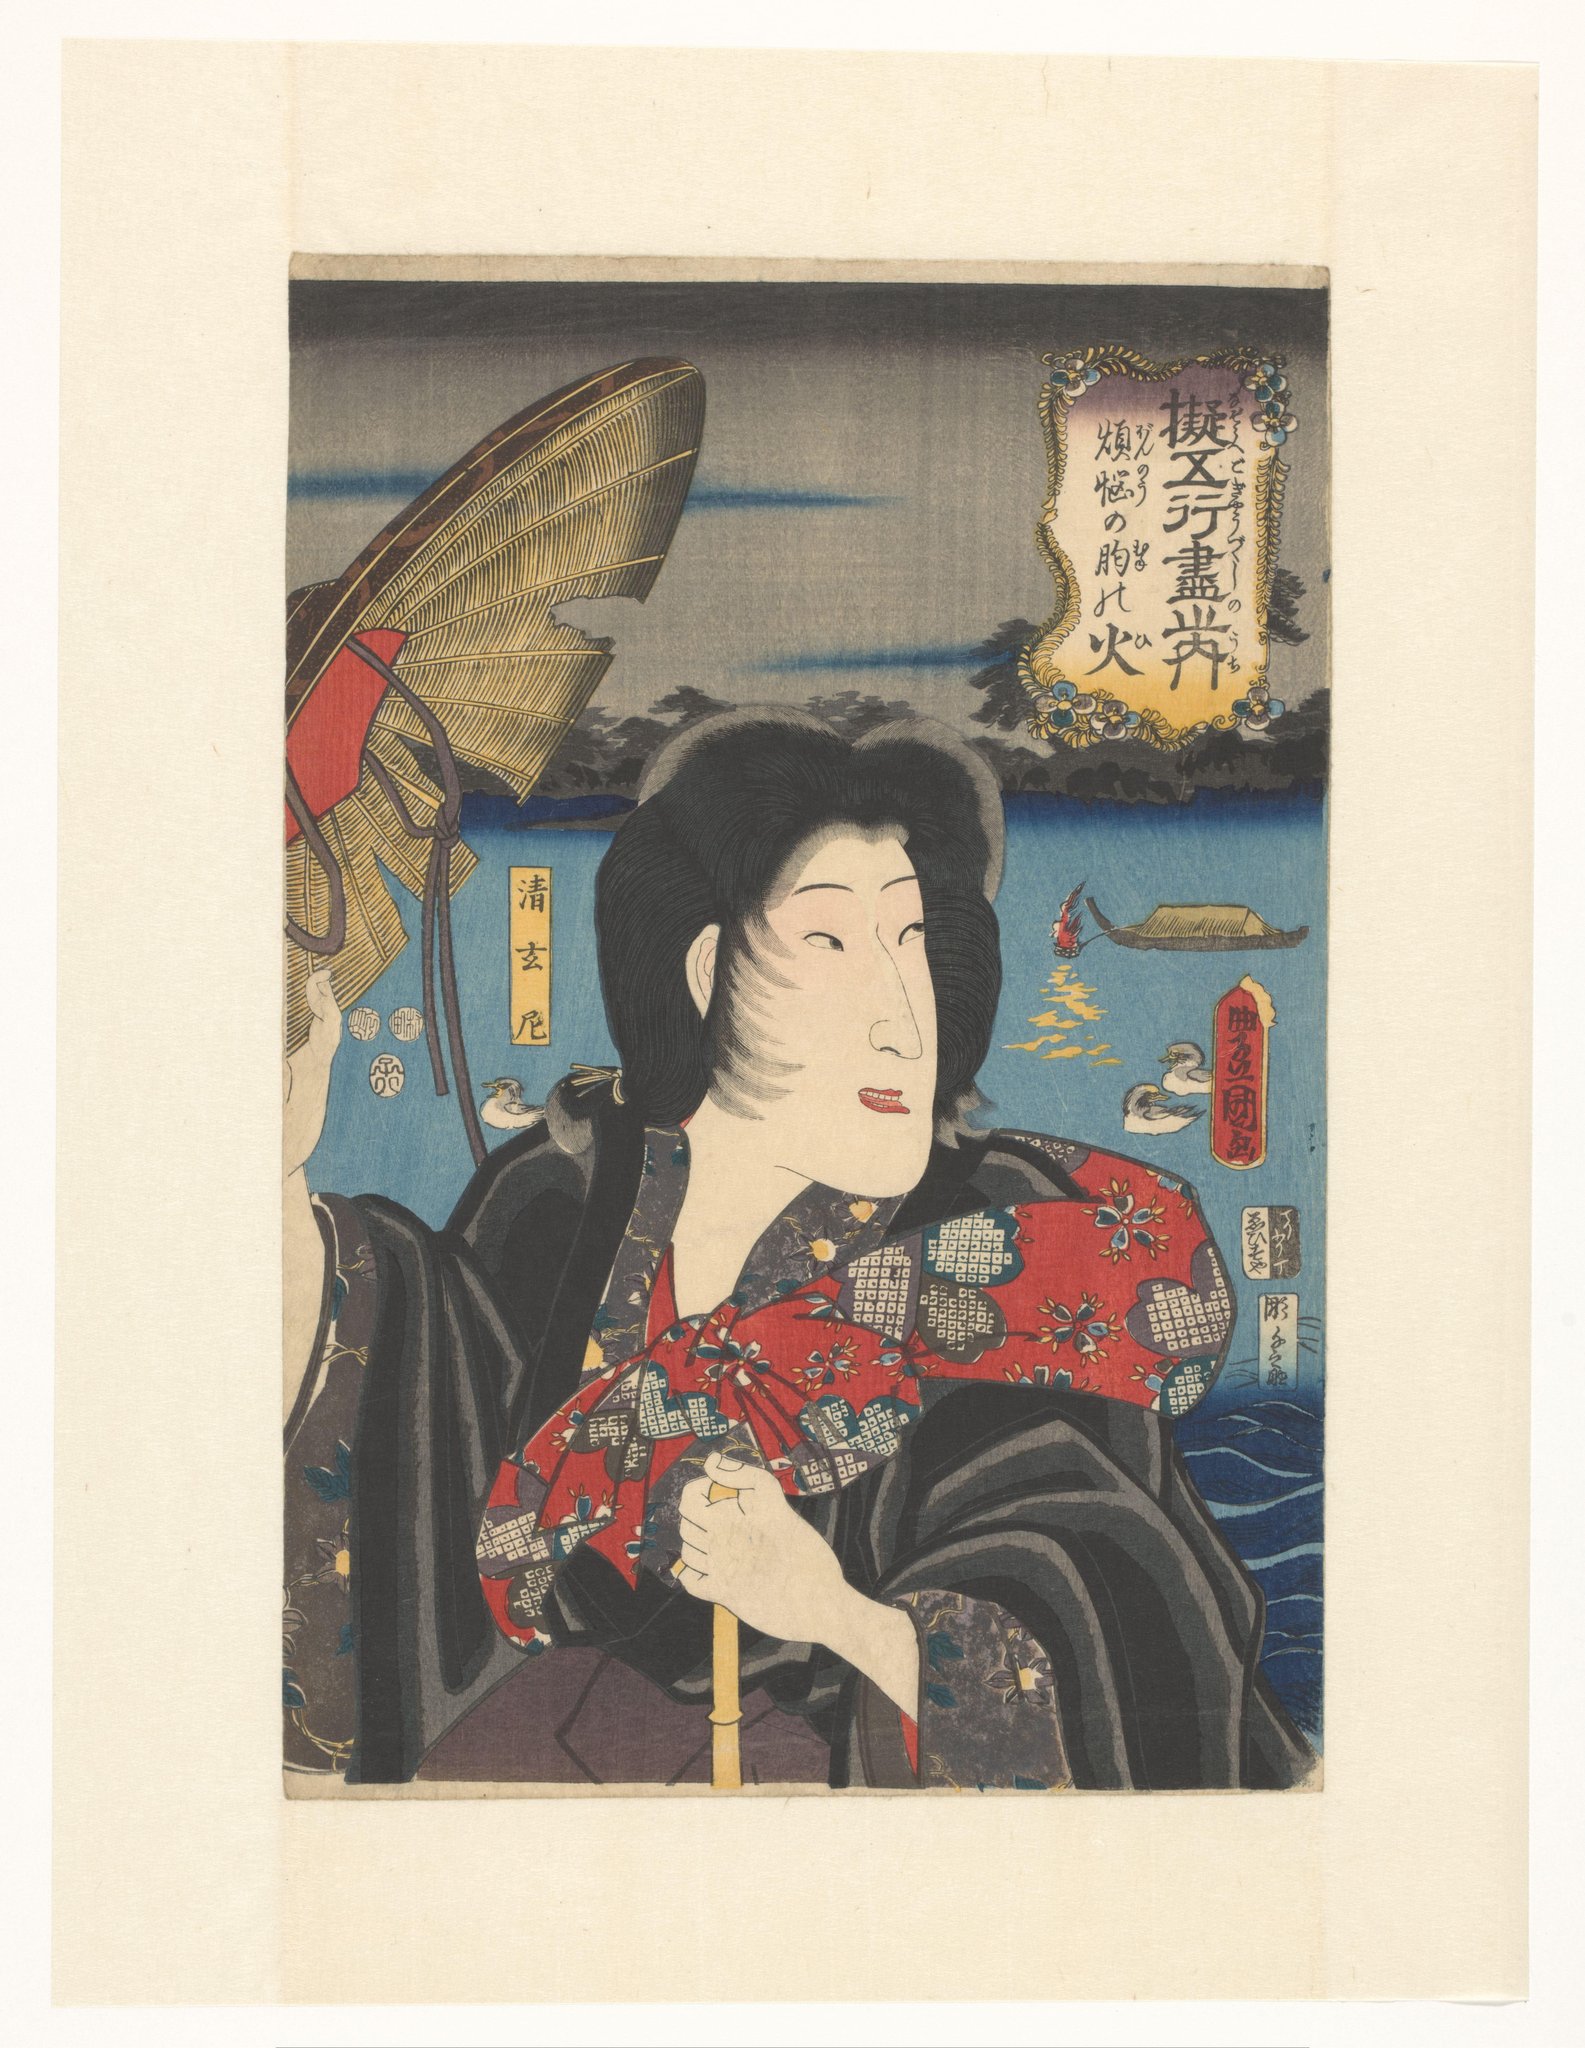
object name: print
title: Compasisons with the five elements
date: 1808-1852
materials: paper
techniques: woodcut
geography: japan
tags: female impersonation by actor, water course, head-gear: hat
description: Kabuki acteur Bandô Shûka I in de rol van de non Seigen, afgebeeld met rieten hoed in haar hand, en wandelstok, bij de rivier de Sumida, waar haar zoon is omgekomen. De bootjes op de achtergrond zijn verlicht met vuren om te vissen, wat aangeeft dat het nacht is.